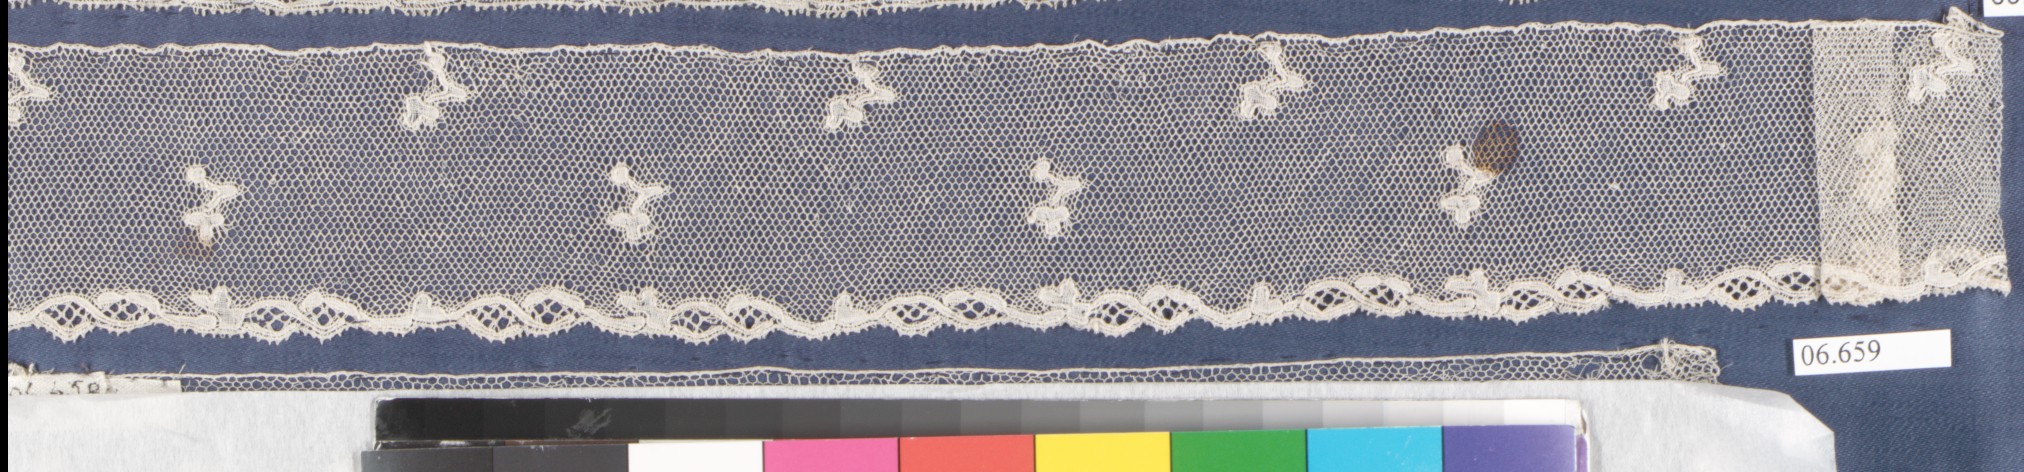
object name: piece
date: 1801-1833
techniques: lace